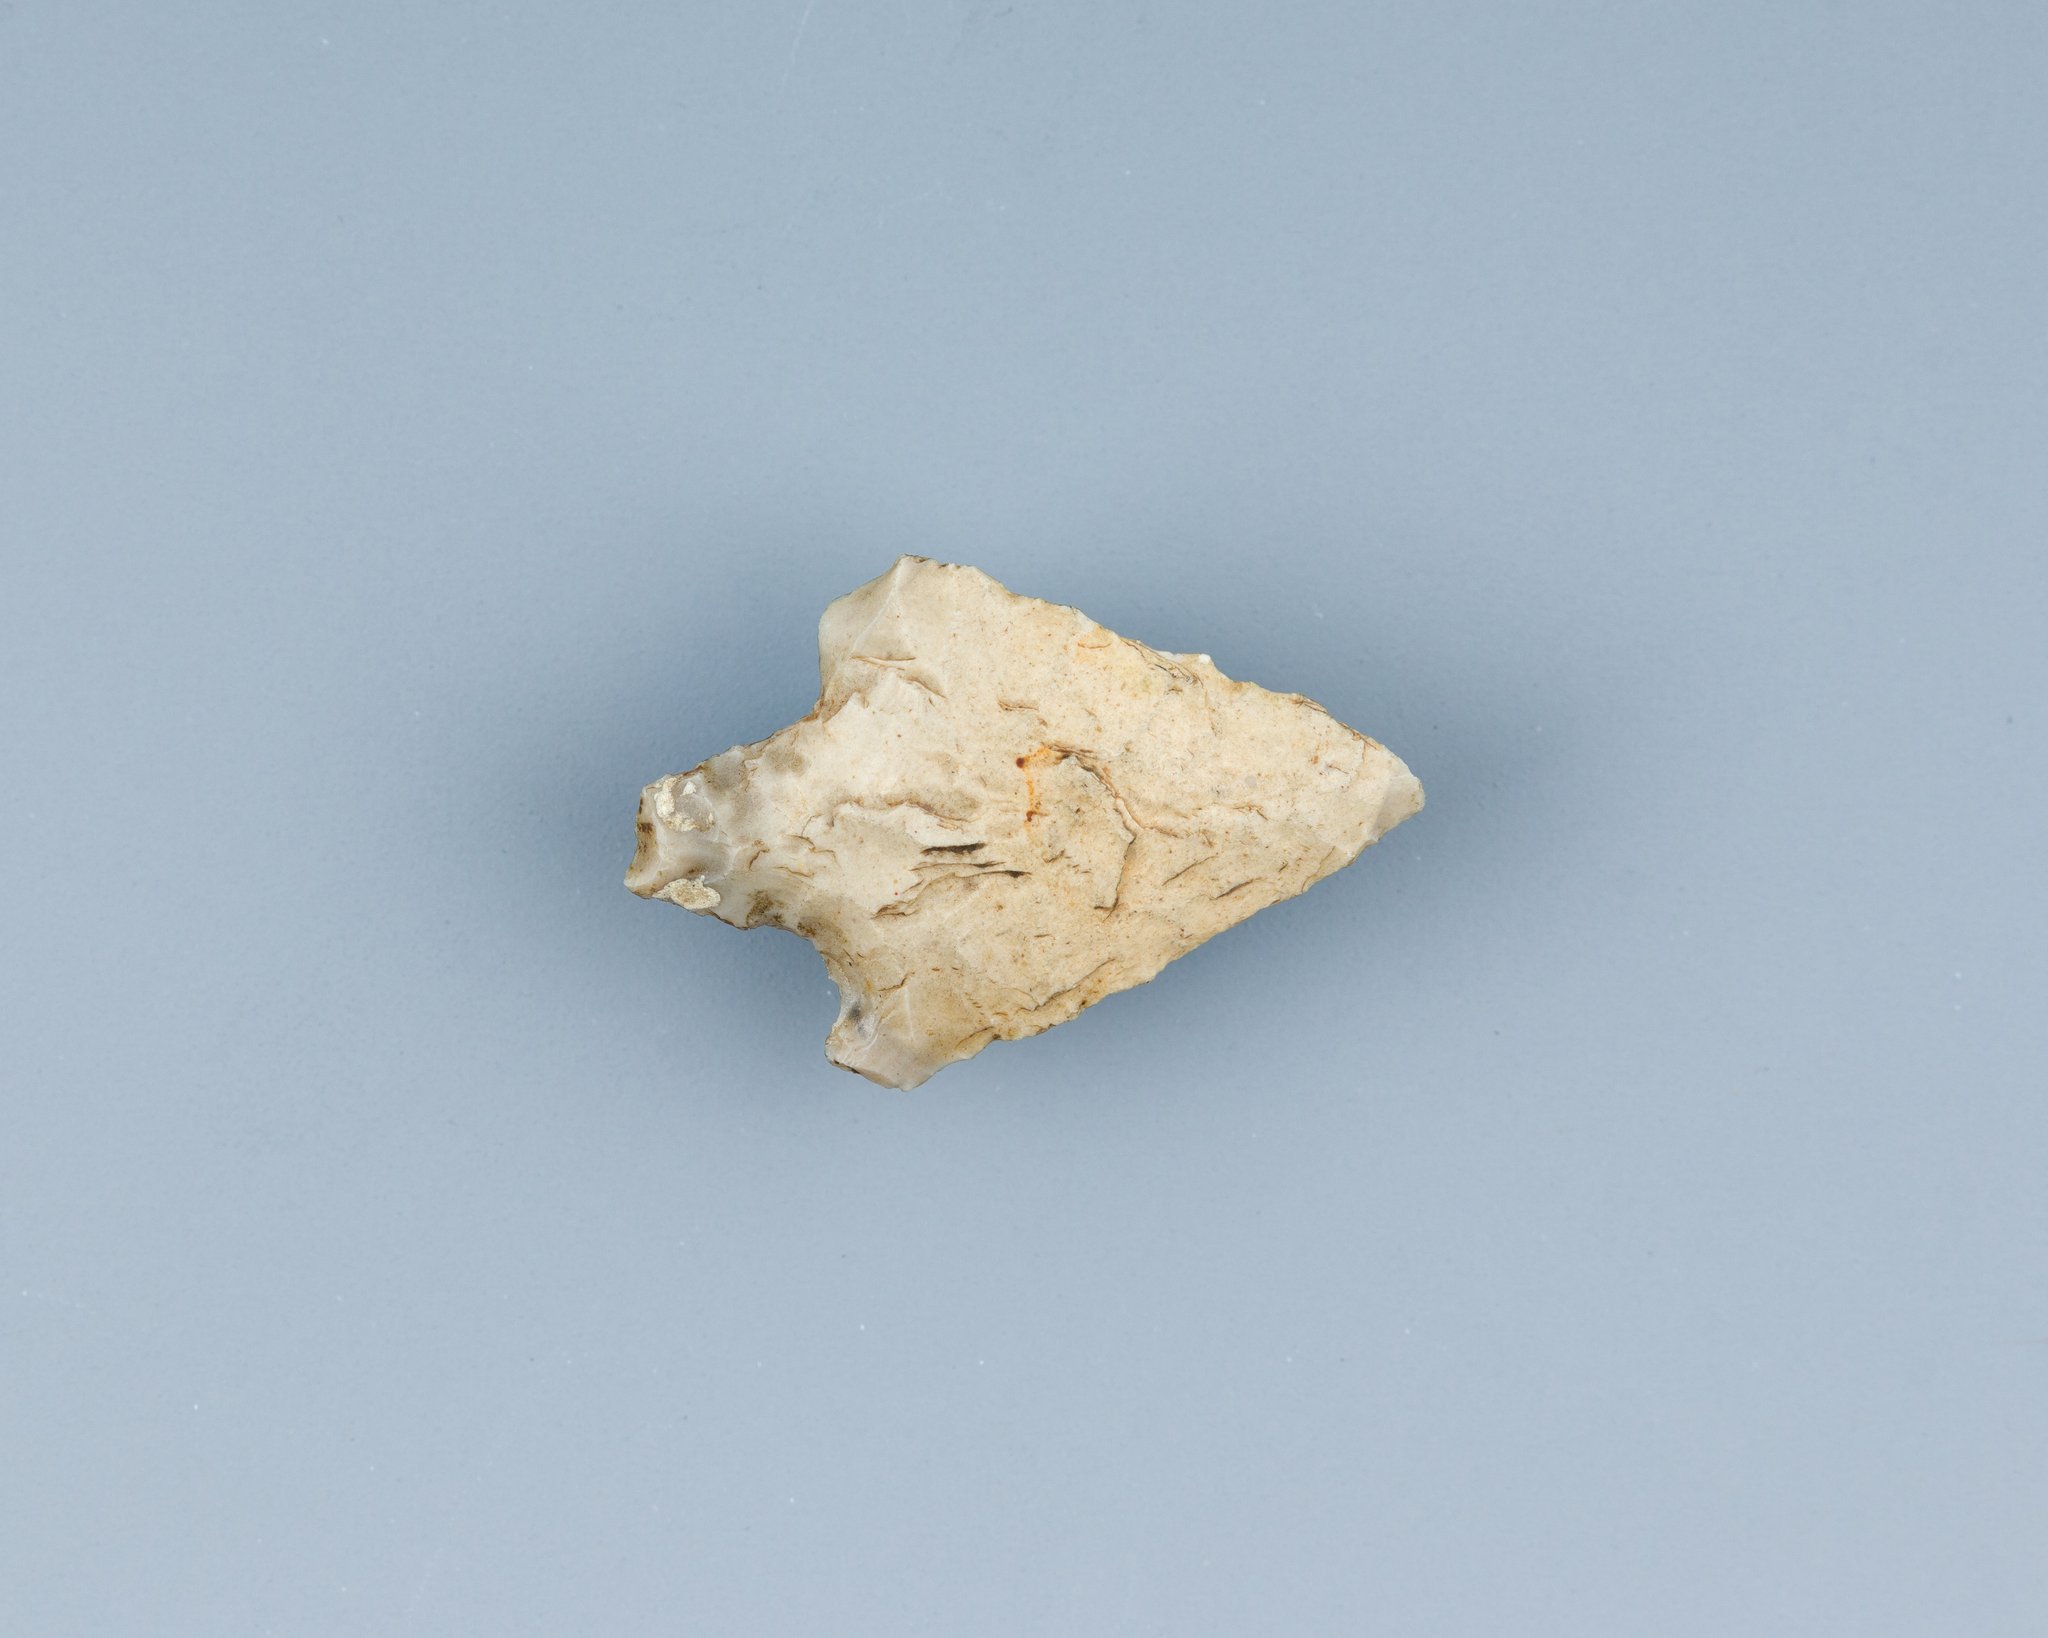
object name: arrowhead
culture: italian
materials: stone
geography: italy